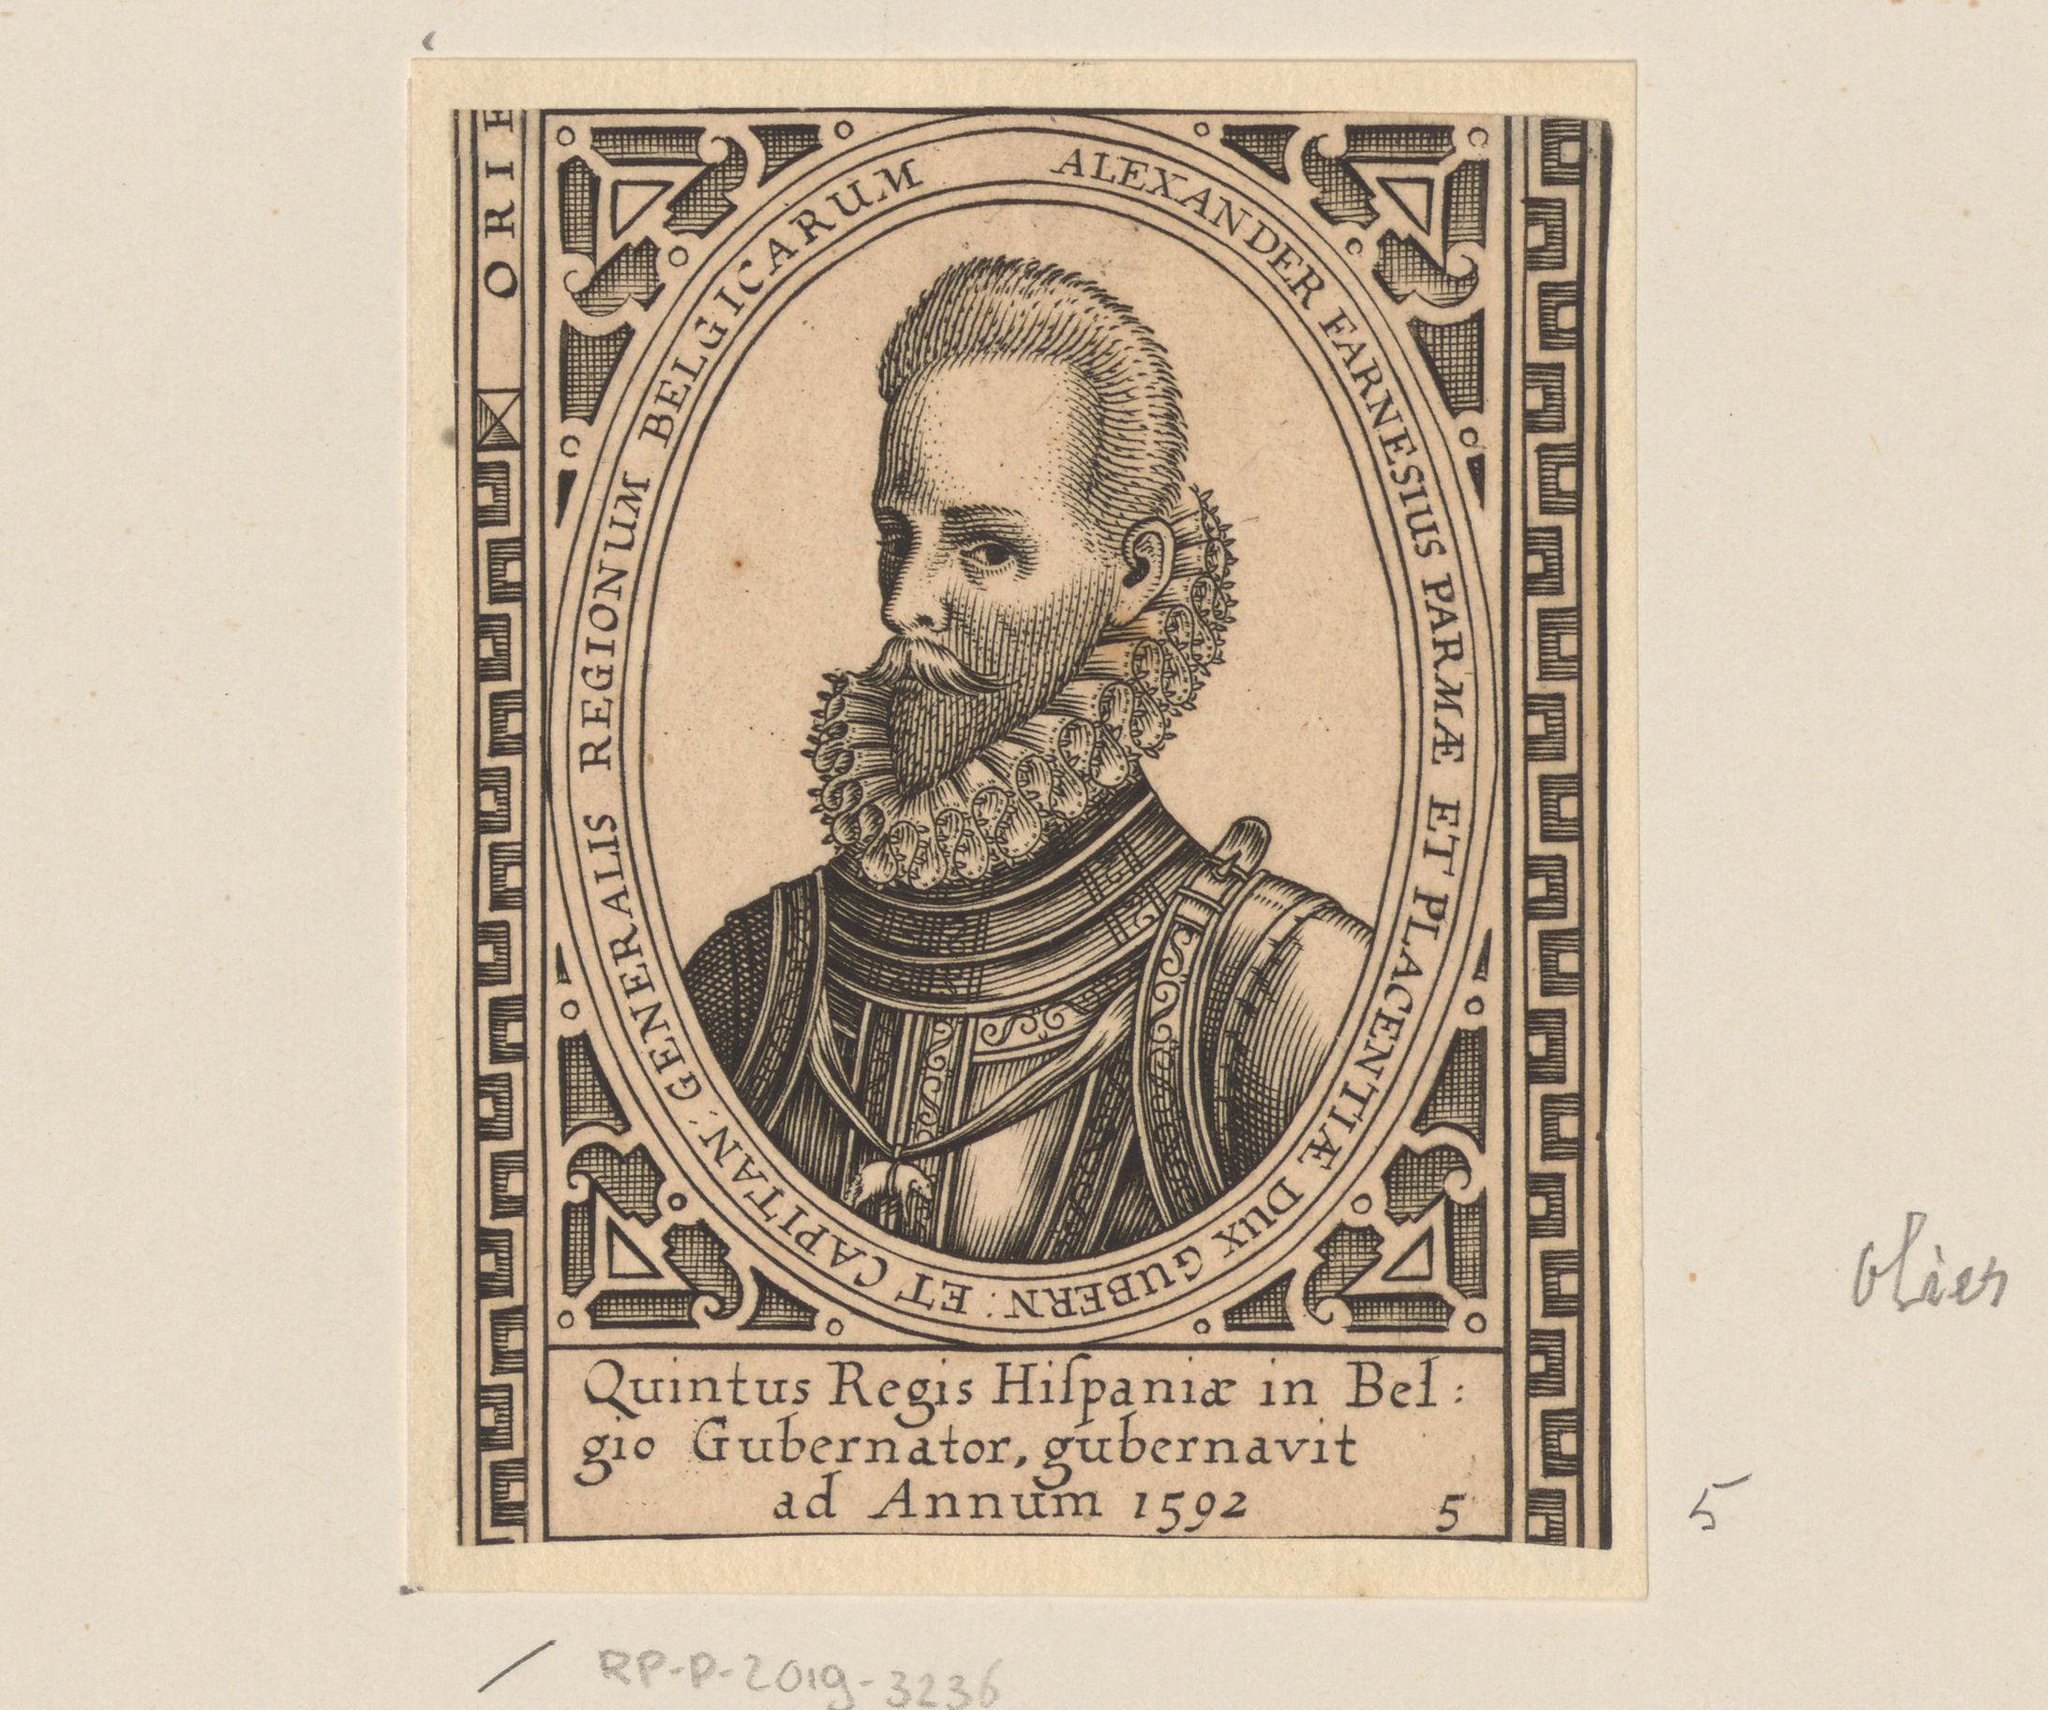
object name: print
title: Portret van Alexander Farnese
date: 1650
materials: paper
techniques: engraving, etching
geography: rotterdam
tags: rome, alessandro farnese (landvoogd van de nederlanden en hertog van parma en piacenza), historical persons, knighthood order of the golden fleece - insignia of a knighthood order, e.g.: badge, chain (with name of order)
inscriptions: (false)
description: Prent afkomsting uit de rand van de Leo Belgicus, een kaart van de Zeventien Provinciën in de vorm van de Nederlandse leeuw, Amsterdam: Claes Jansz. Visscher, 1650.